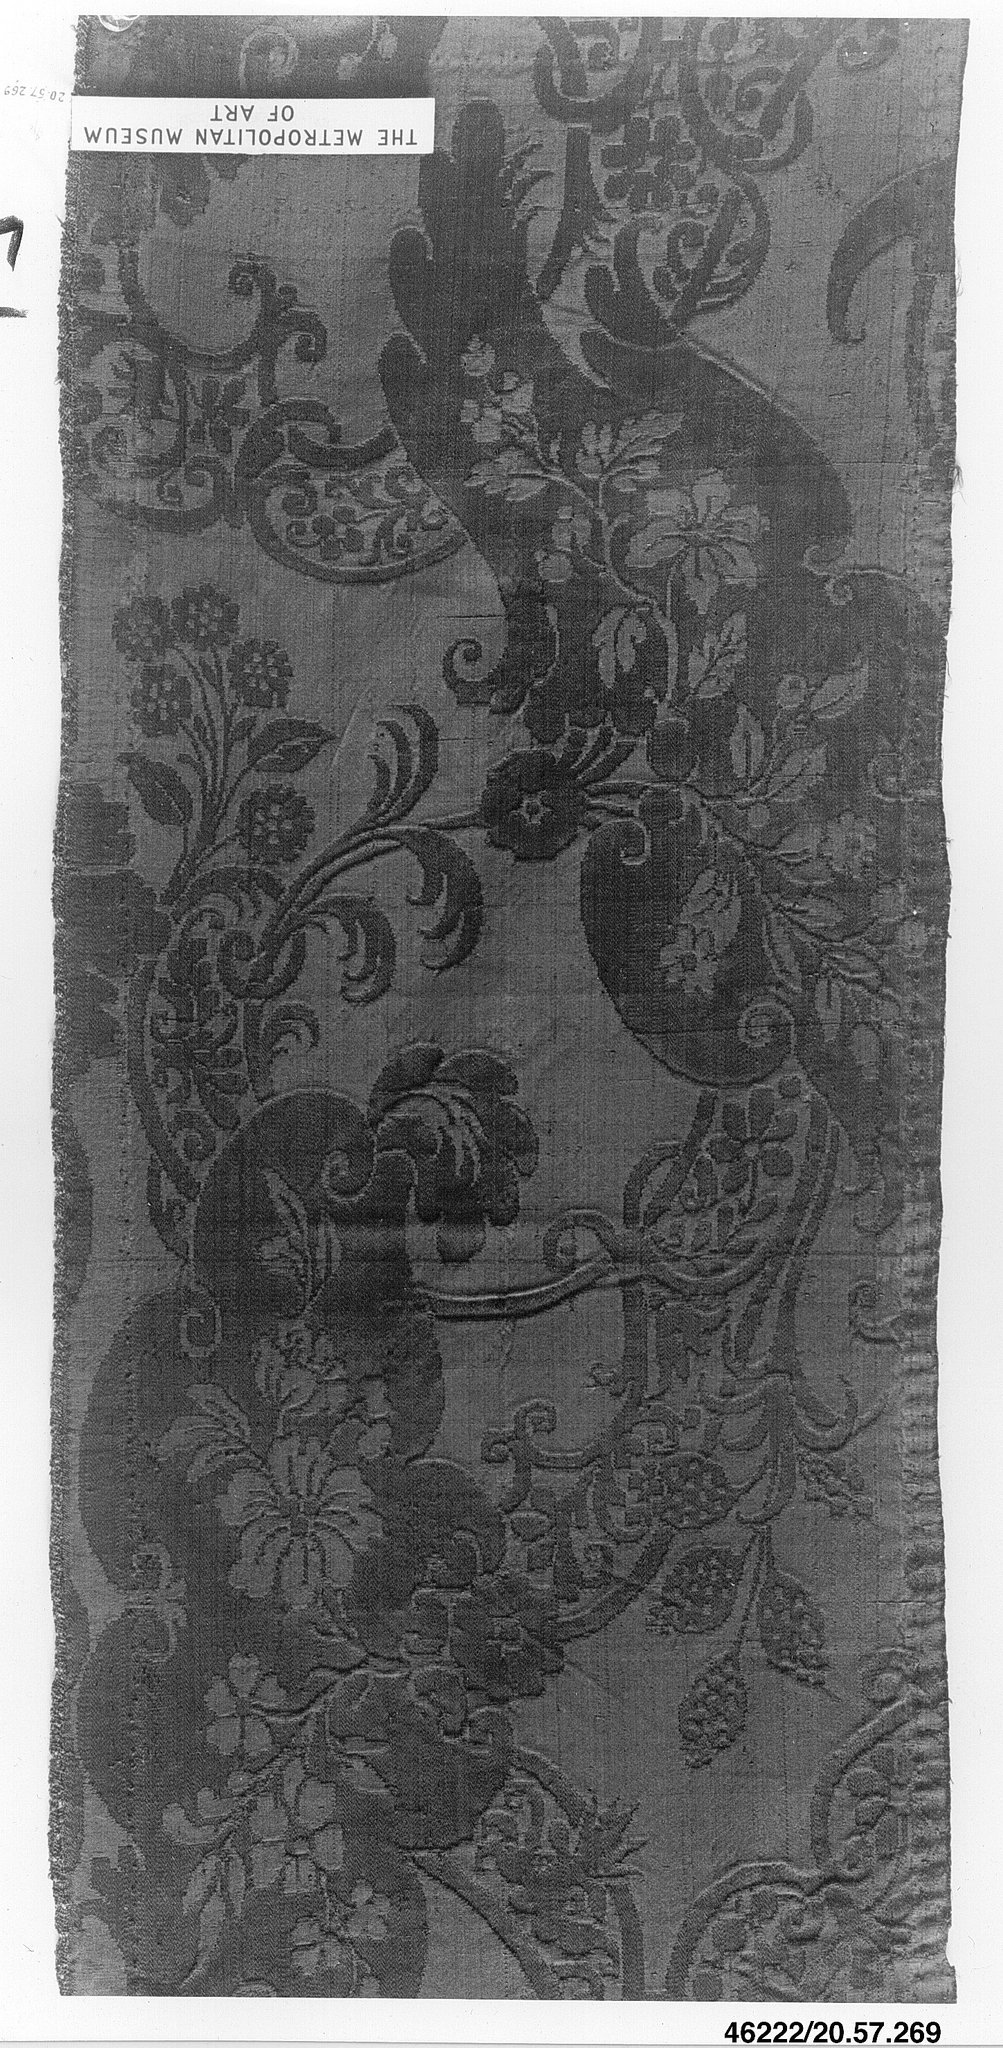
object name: piece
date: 1715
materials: silk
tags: flowers,leaves